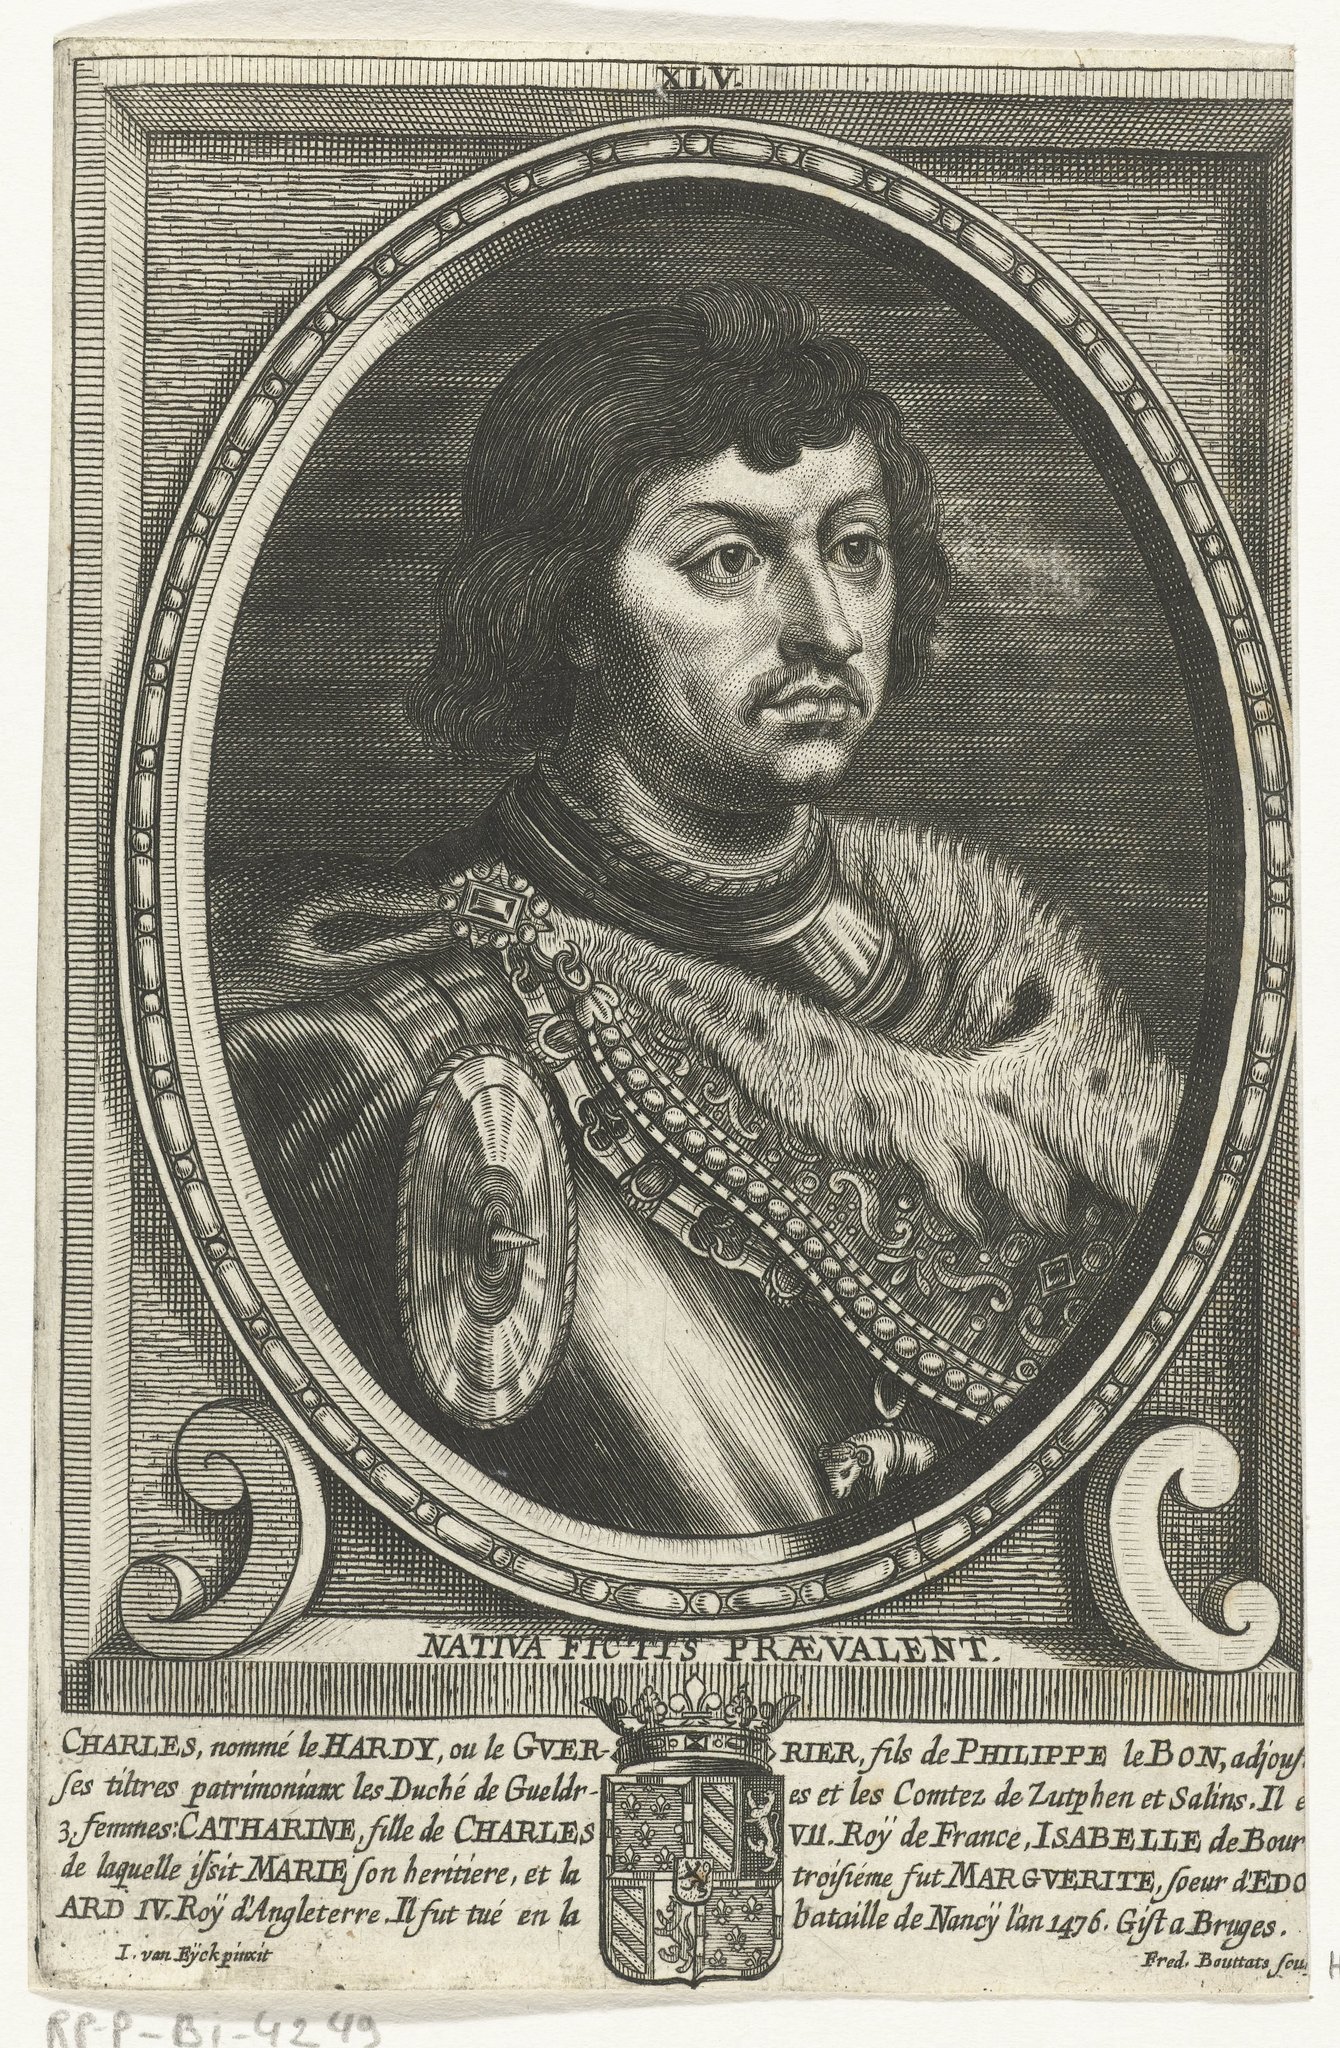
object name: print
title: Portret van Karel de Stoute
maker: frederik bouttats (i)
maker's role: artist, painter, print maker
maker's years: 1590-1661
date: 1600-1676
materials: paper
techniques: engraving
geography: antwerp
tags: earl, charles the bold (duke of burgundy)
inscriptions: collector's mark: Lugt 1838, collector's mark: Lugt 240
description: Portret in een ovale lijst van Karel de Stoute, hertog van Bourgondië. Buste naar rechts. Karel de Stoute draagt de keten van de Orde van Het Gulden Vlies. De prent heeft een Frans onderschrift met de naam van de geportretteerde en wat informatie over zijn leven.